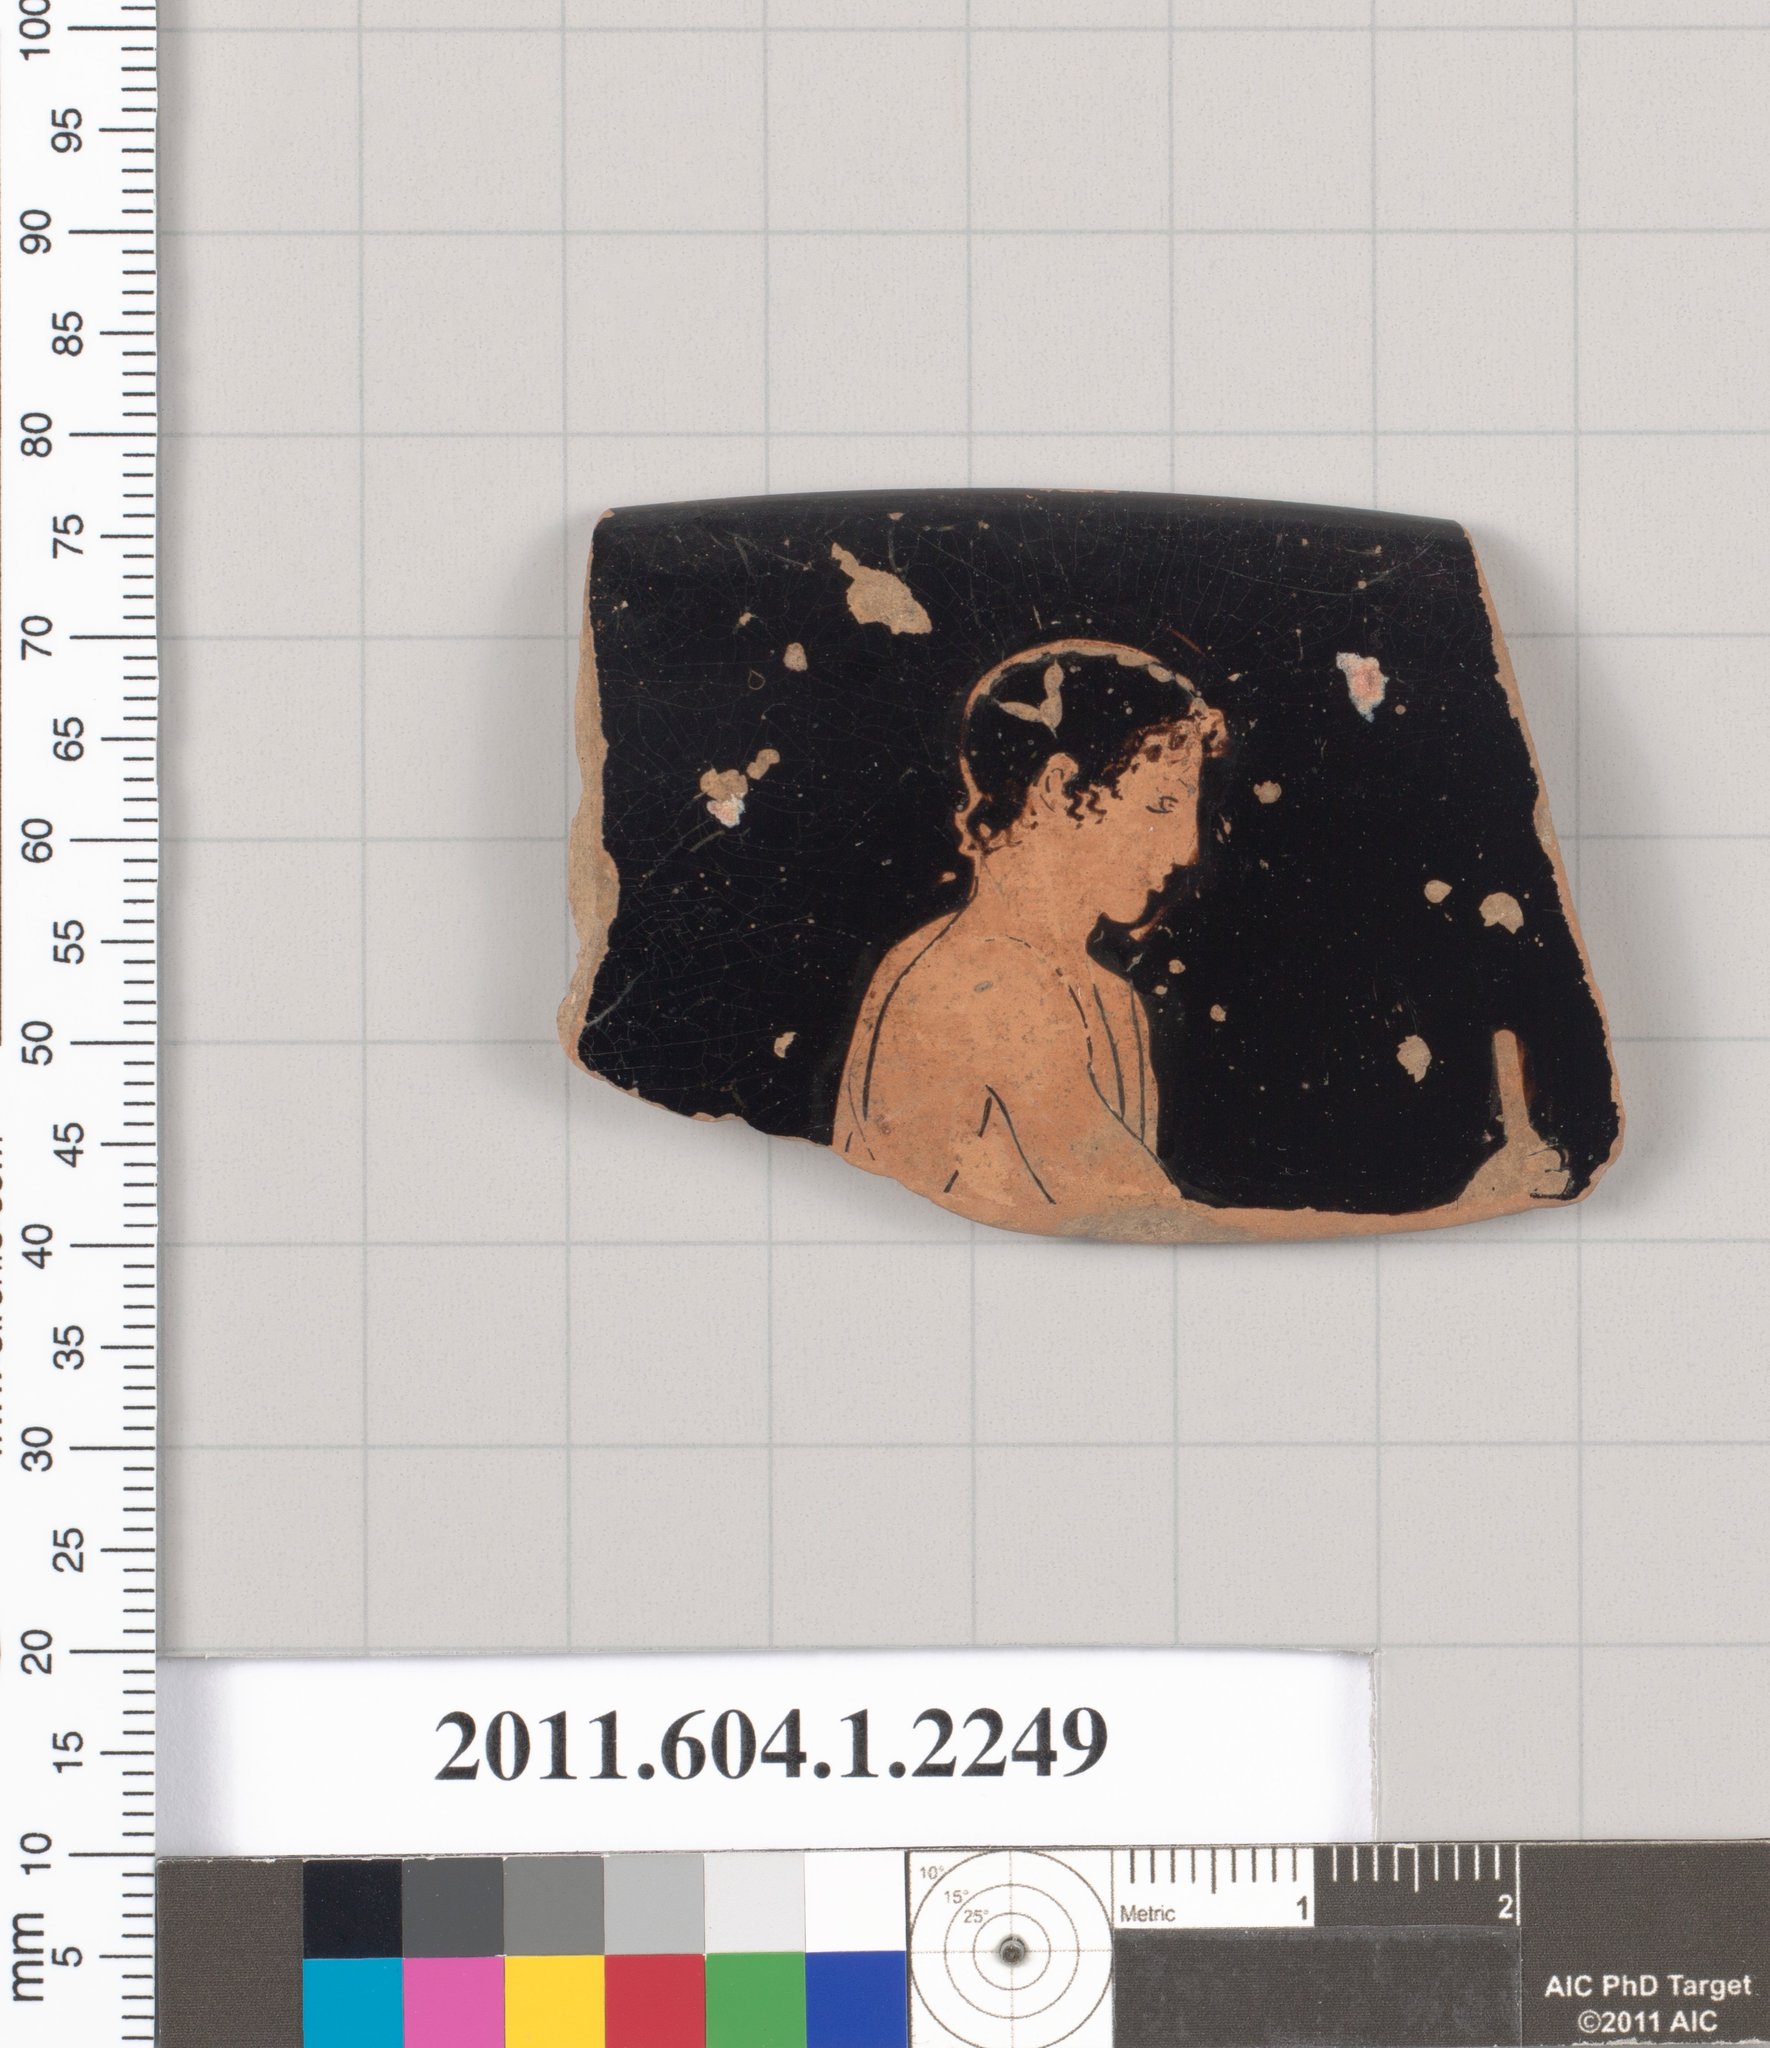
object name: kylix fragment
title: Terracotta rim fragment of a kylix (drinking cup)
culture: greek, attic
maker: lyandros painter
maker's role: artist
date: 470-460 BCE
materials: terracotta